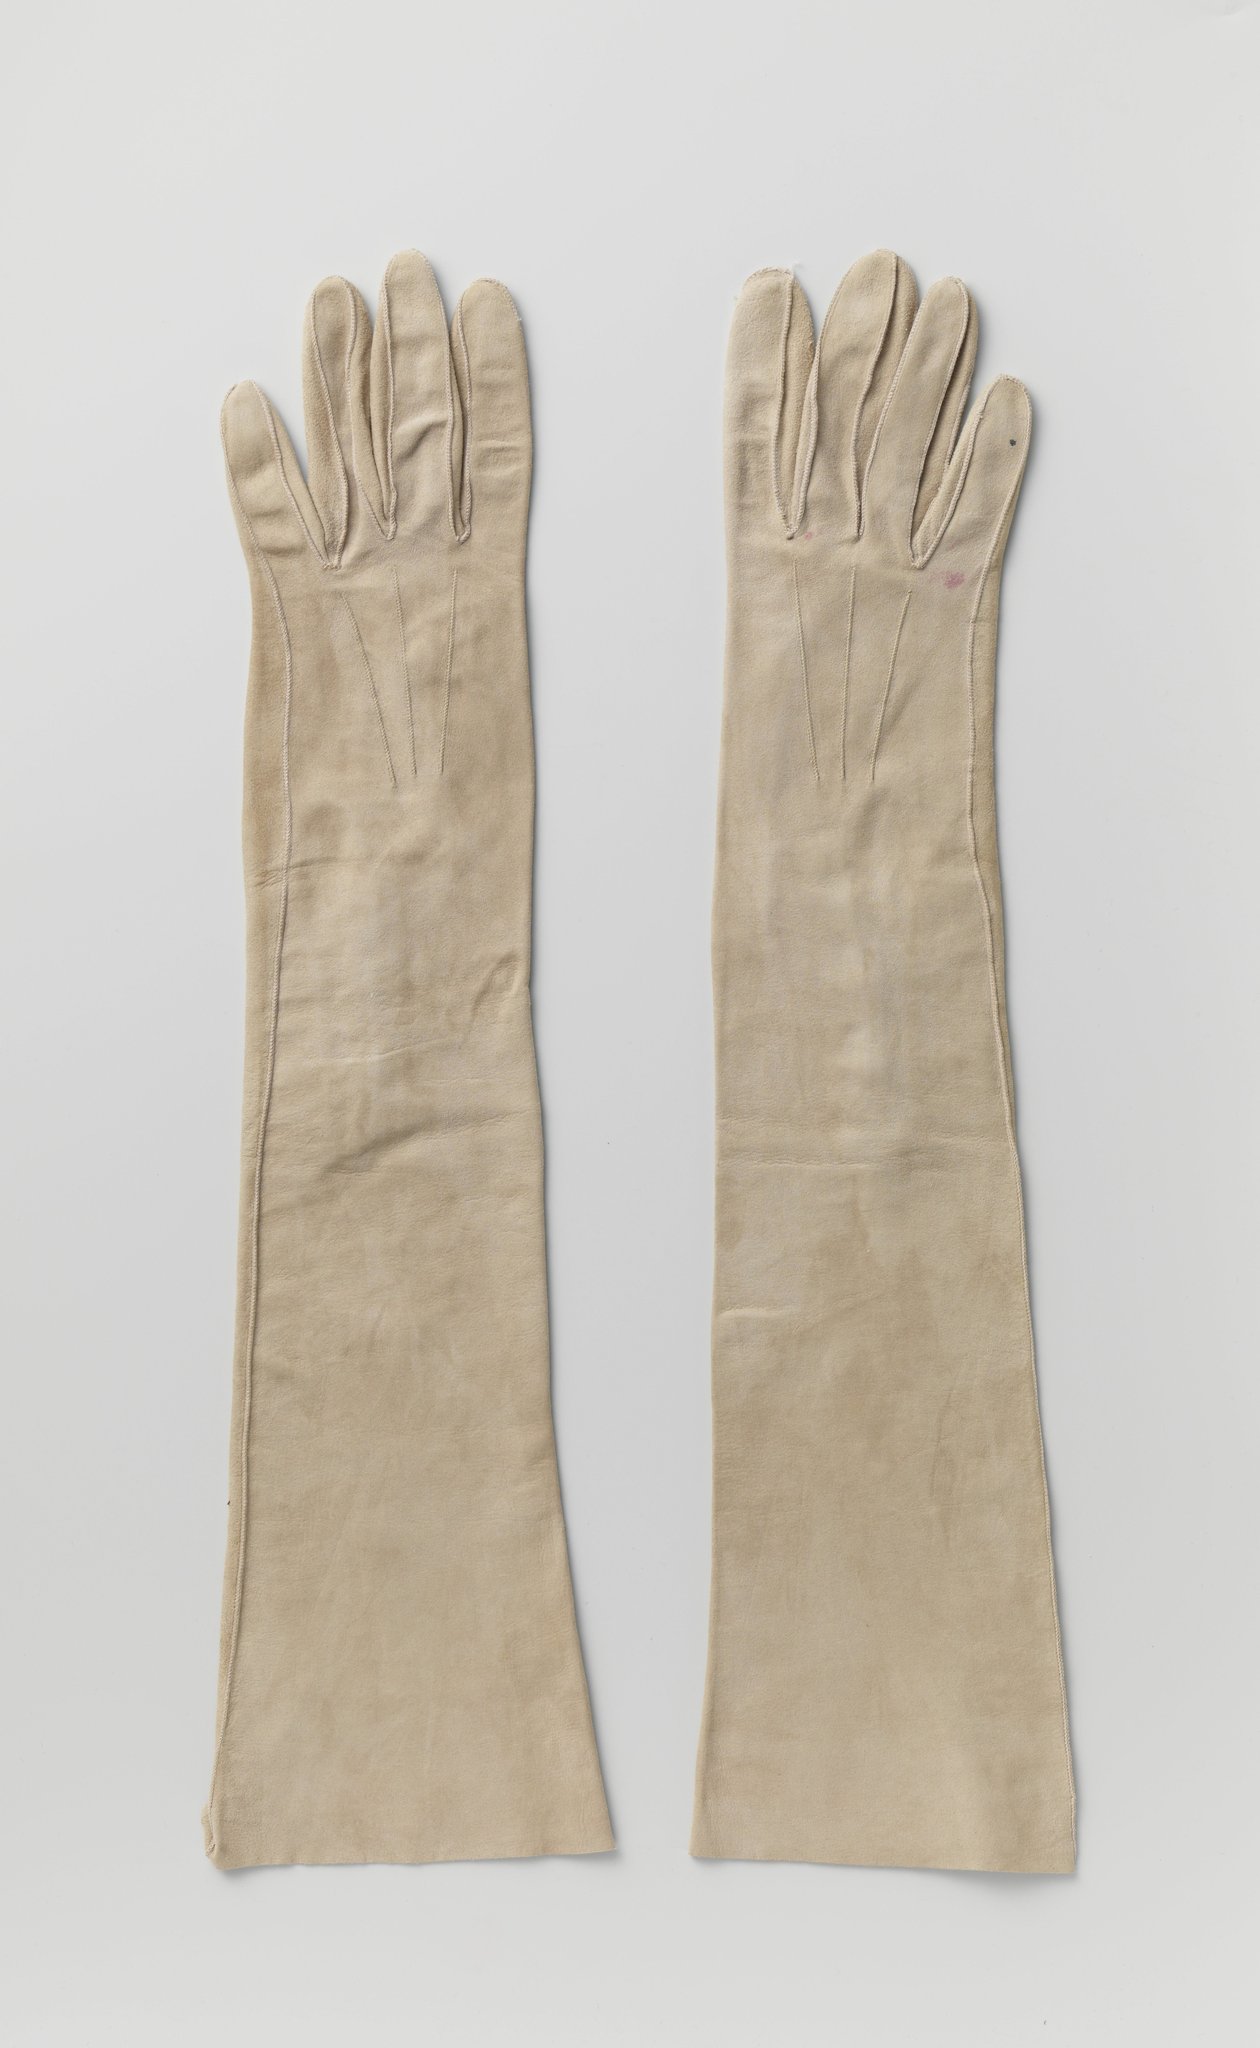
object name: glove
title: Handschoen van leverkleurig zeemleer met drie kunsstof knopen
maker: Anonymous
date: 1900-1915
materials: leather, plastic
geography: netherlands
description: Rechterhandschoen van leverkleurig zeemleer, bij de pols een split met drie kunsstof paarse parelmoeren knopen, op de rug drie uitstralende koorden.